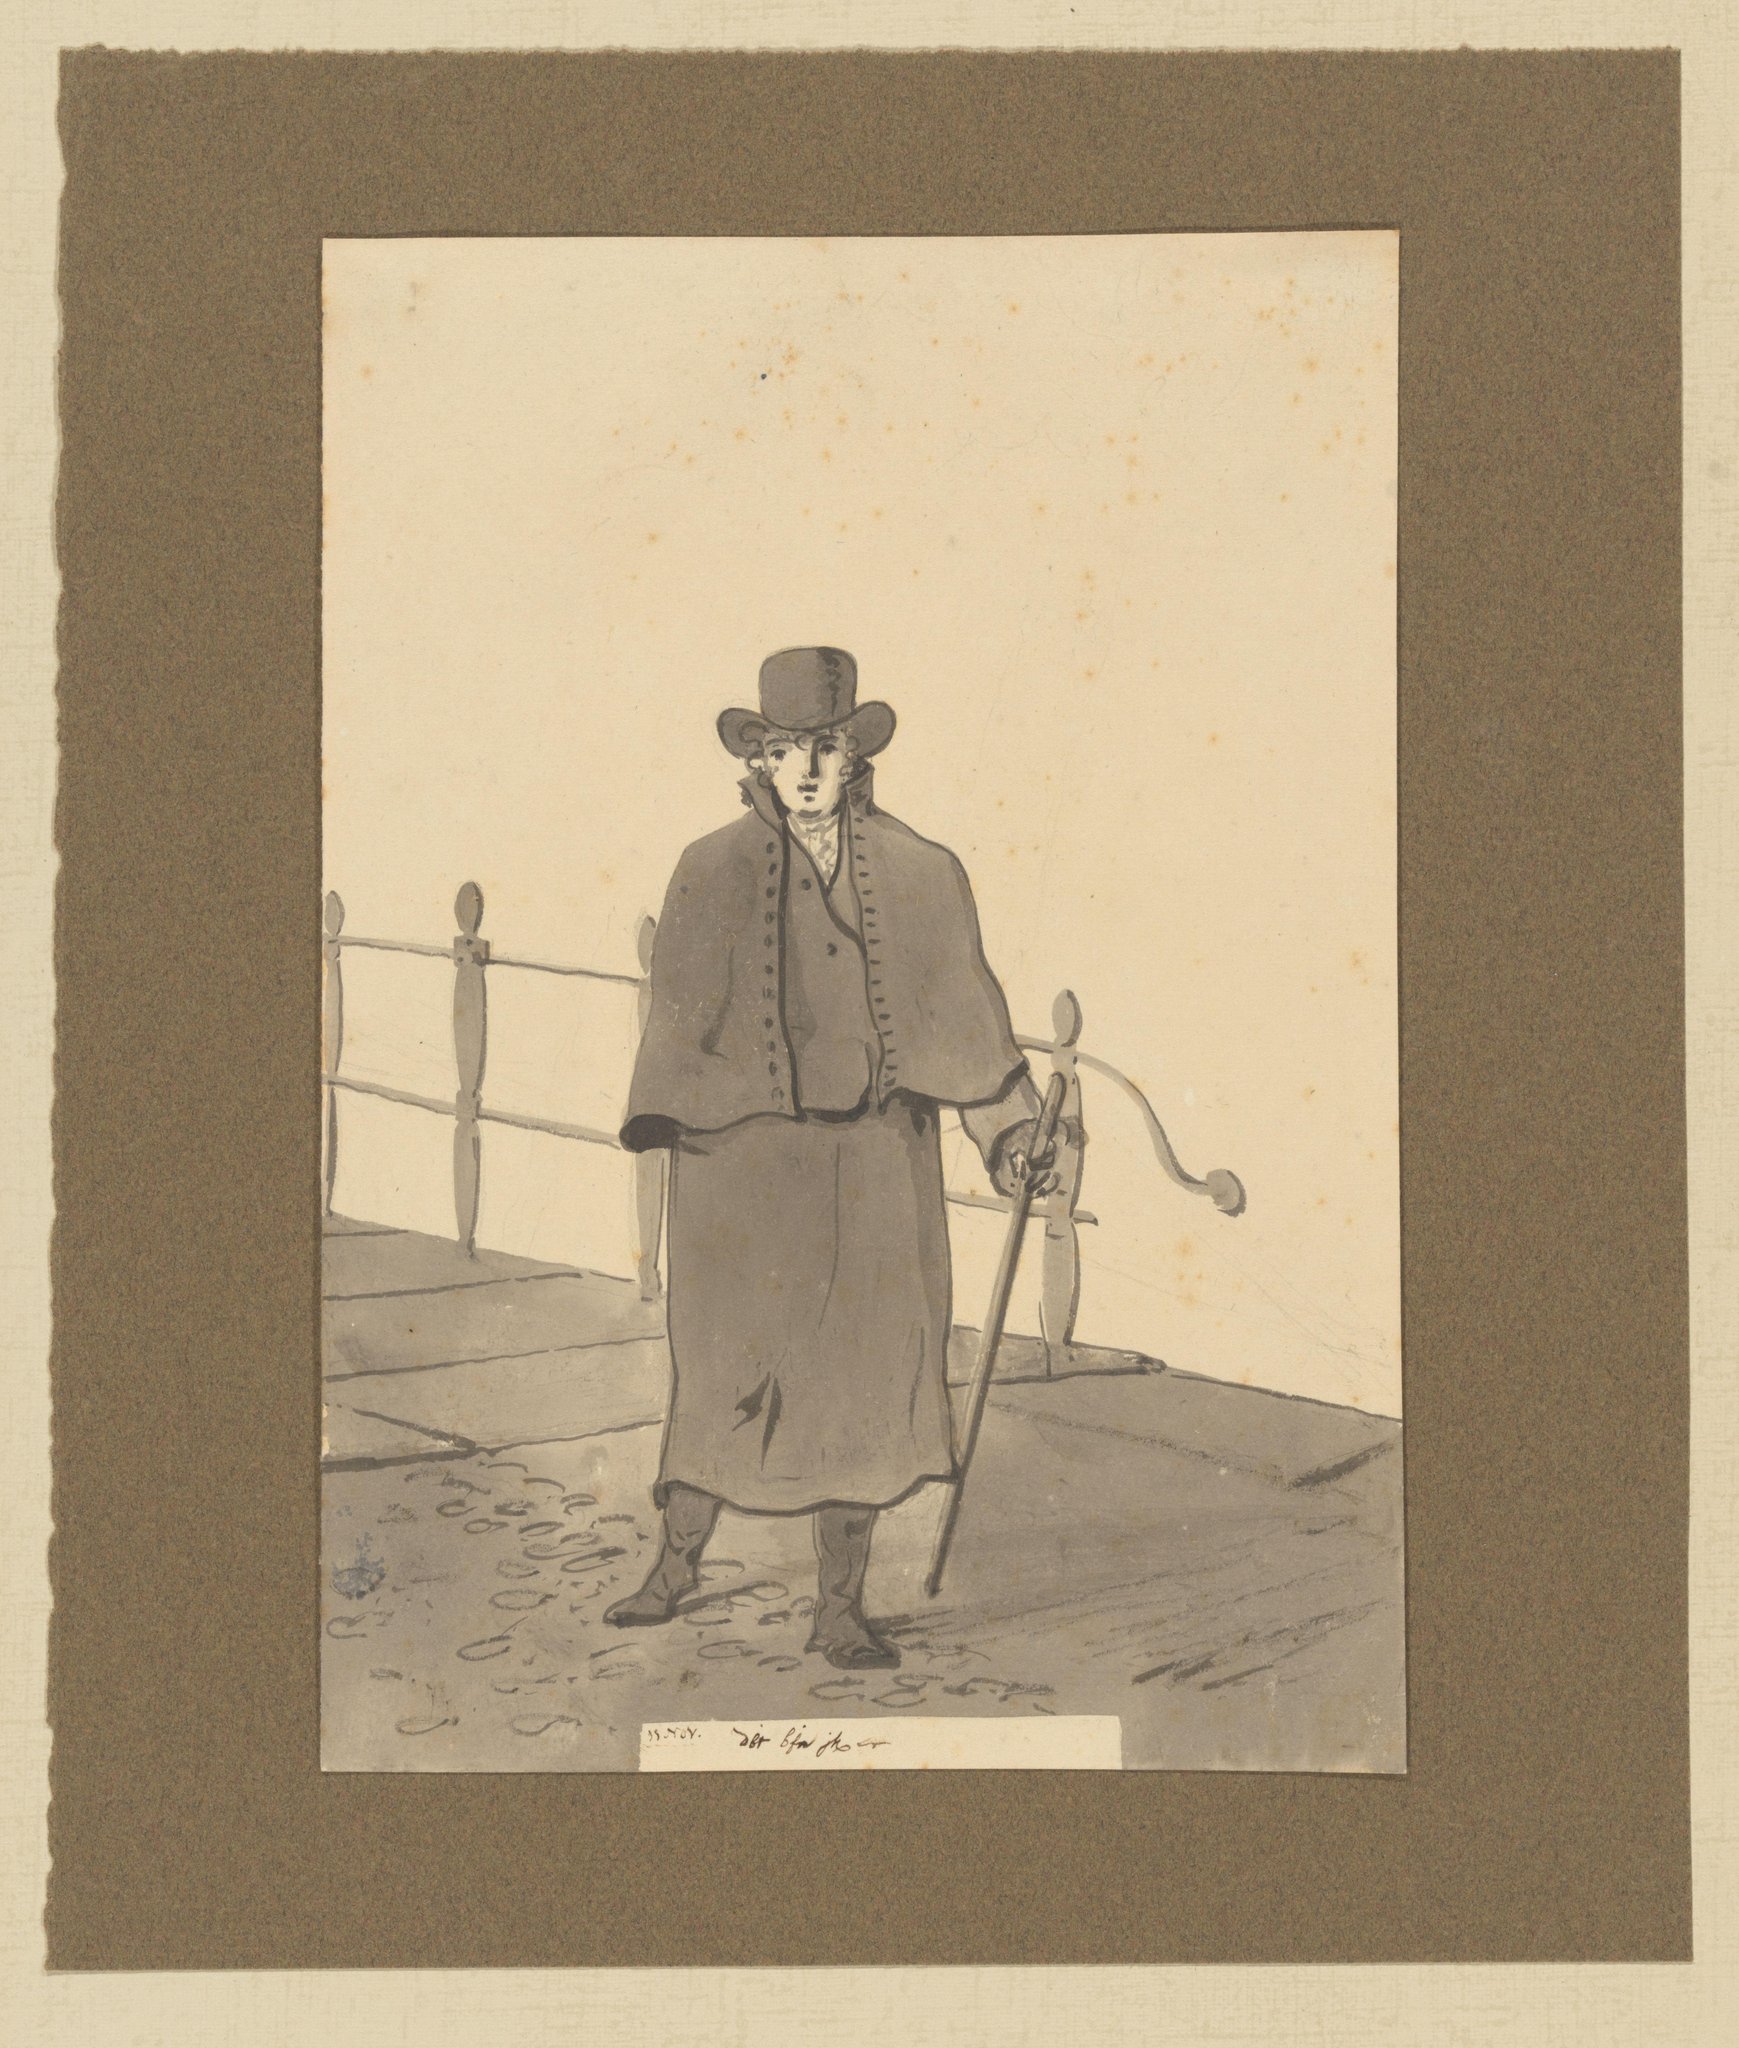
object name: drawing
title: Self-portrait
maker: christiaan andriessen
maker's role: draughtsman, print maker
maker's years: 1775-1846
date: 1806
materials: chalk, graphite, paper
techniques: brush, drawing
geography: amsterdam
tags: amsterdam, print maker, draughtsman, christiaan andriessen, walking-stick, staff, historical persons, portrait, self-portrait of artist, bridge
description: A full-length frontal portrait of a man in a frock coat and top hat, holding a walking stock. Seen behind him is a railing, likely of a canal bridge.